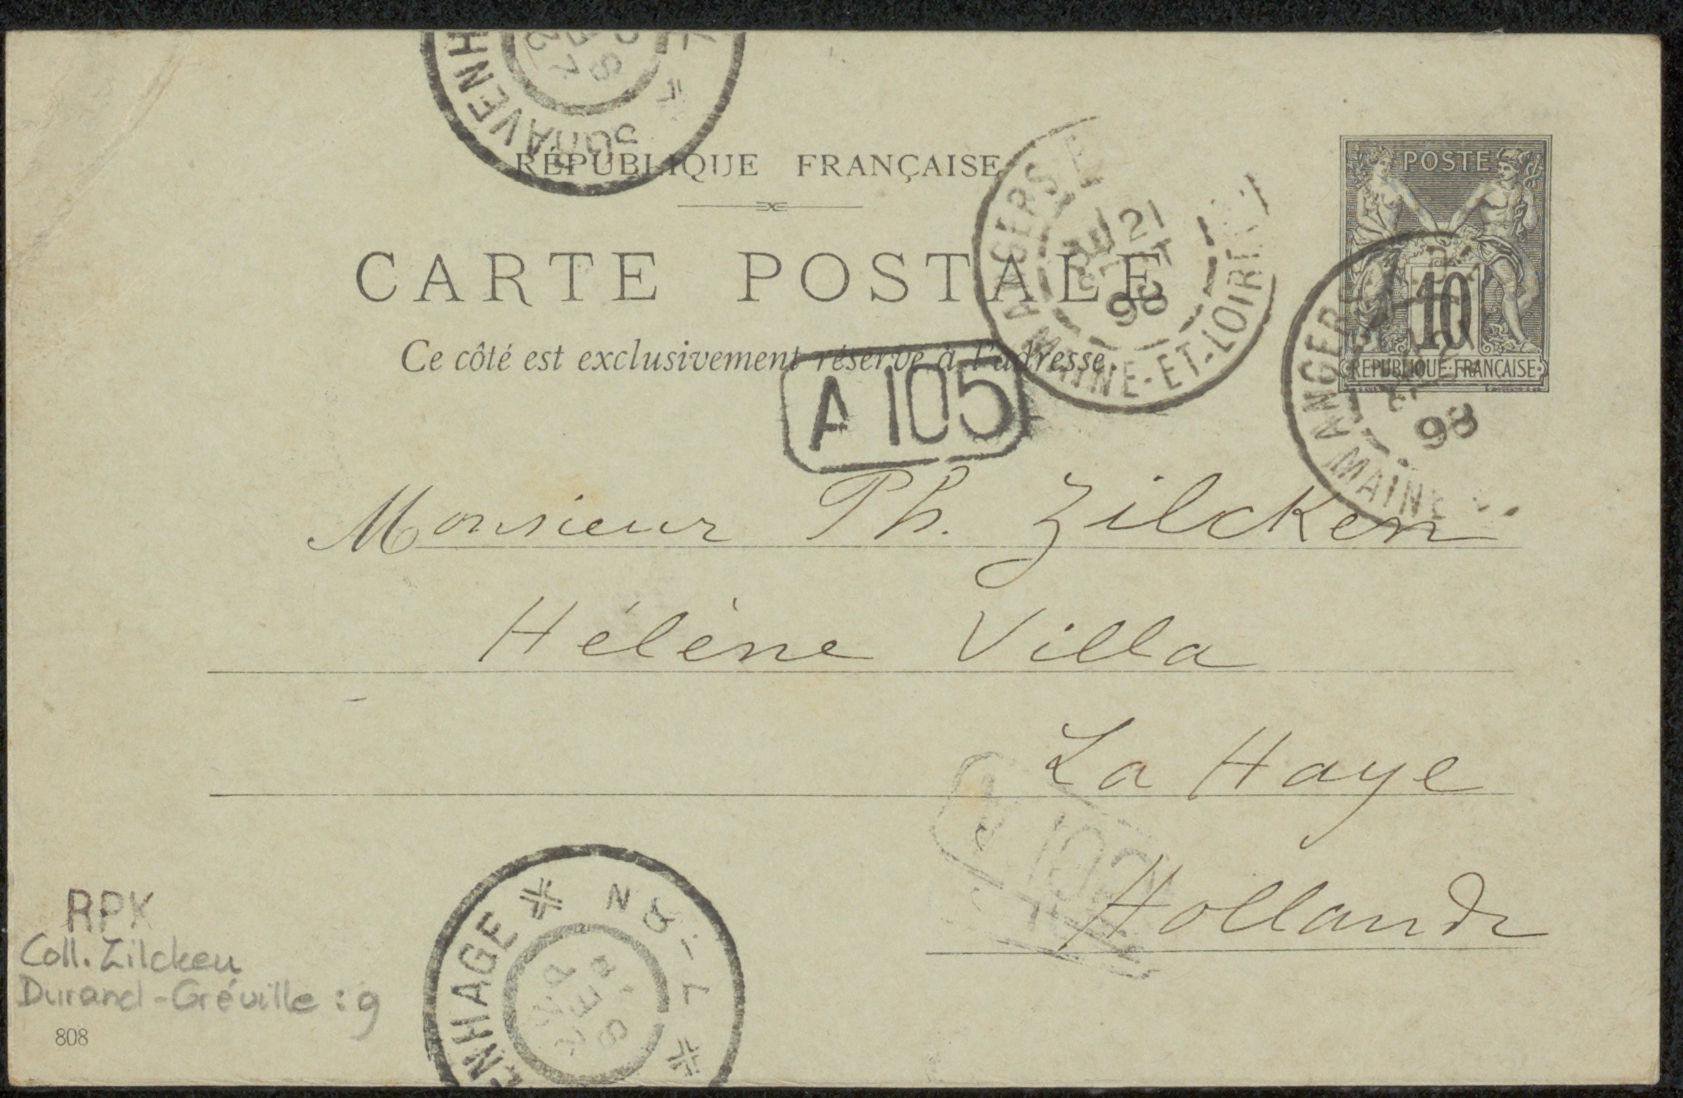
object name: postcard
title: Briefkaart aan Philip Zilcken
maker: émile durand-gréville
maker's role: schrijver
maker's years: 1838-1914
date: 1898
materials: cardboard, ink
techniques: pen, writing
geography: angers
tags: leiden, print maker, rembrandt van rijn, marseille, gabriel mourey, the hague, painter, draughtsman, philip zilcken, criticizing and discussing art, art criticism, exhibition ~ art, amsterdam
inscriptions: collector's mark: ‘RPK’